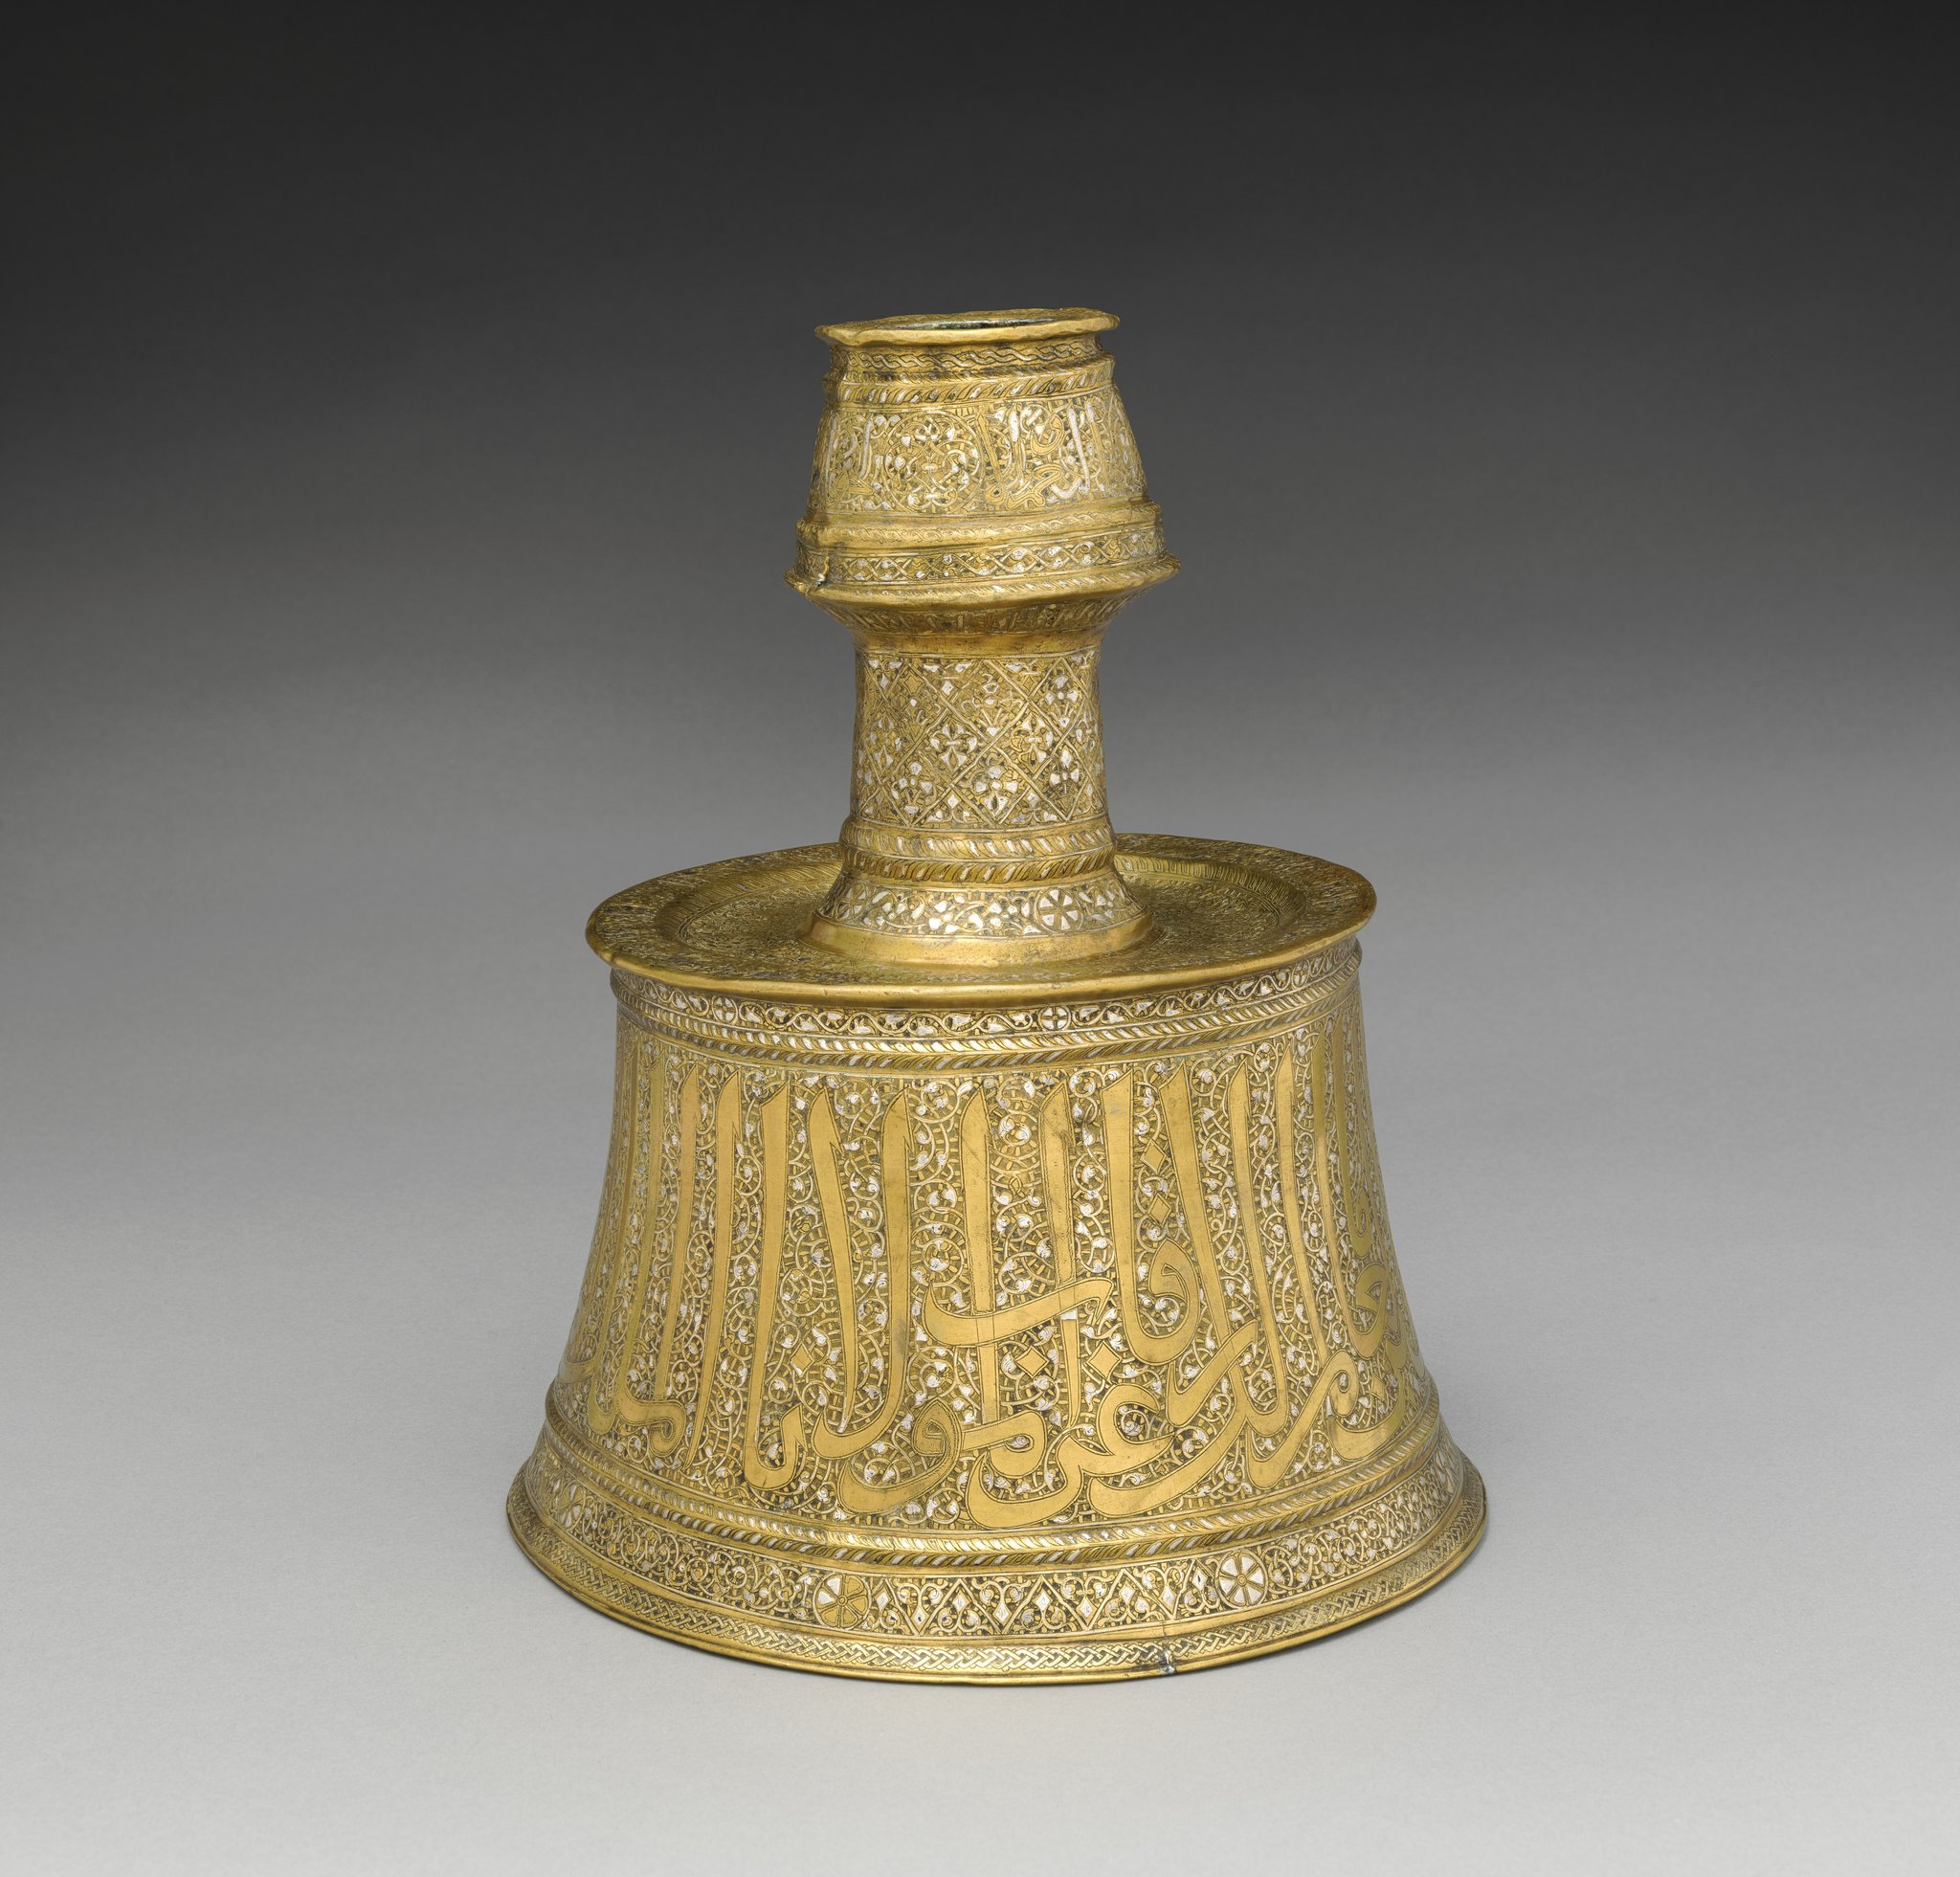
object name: candlestick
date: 1301-1350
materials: brass, silver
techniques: inlay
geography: egypt or syria